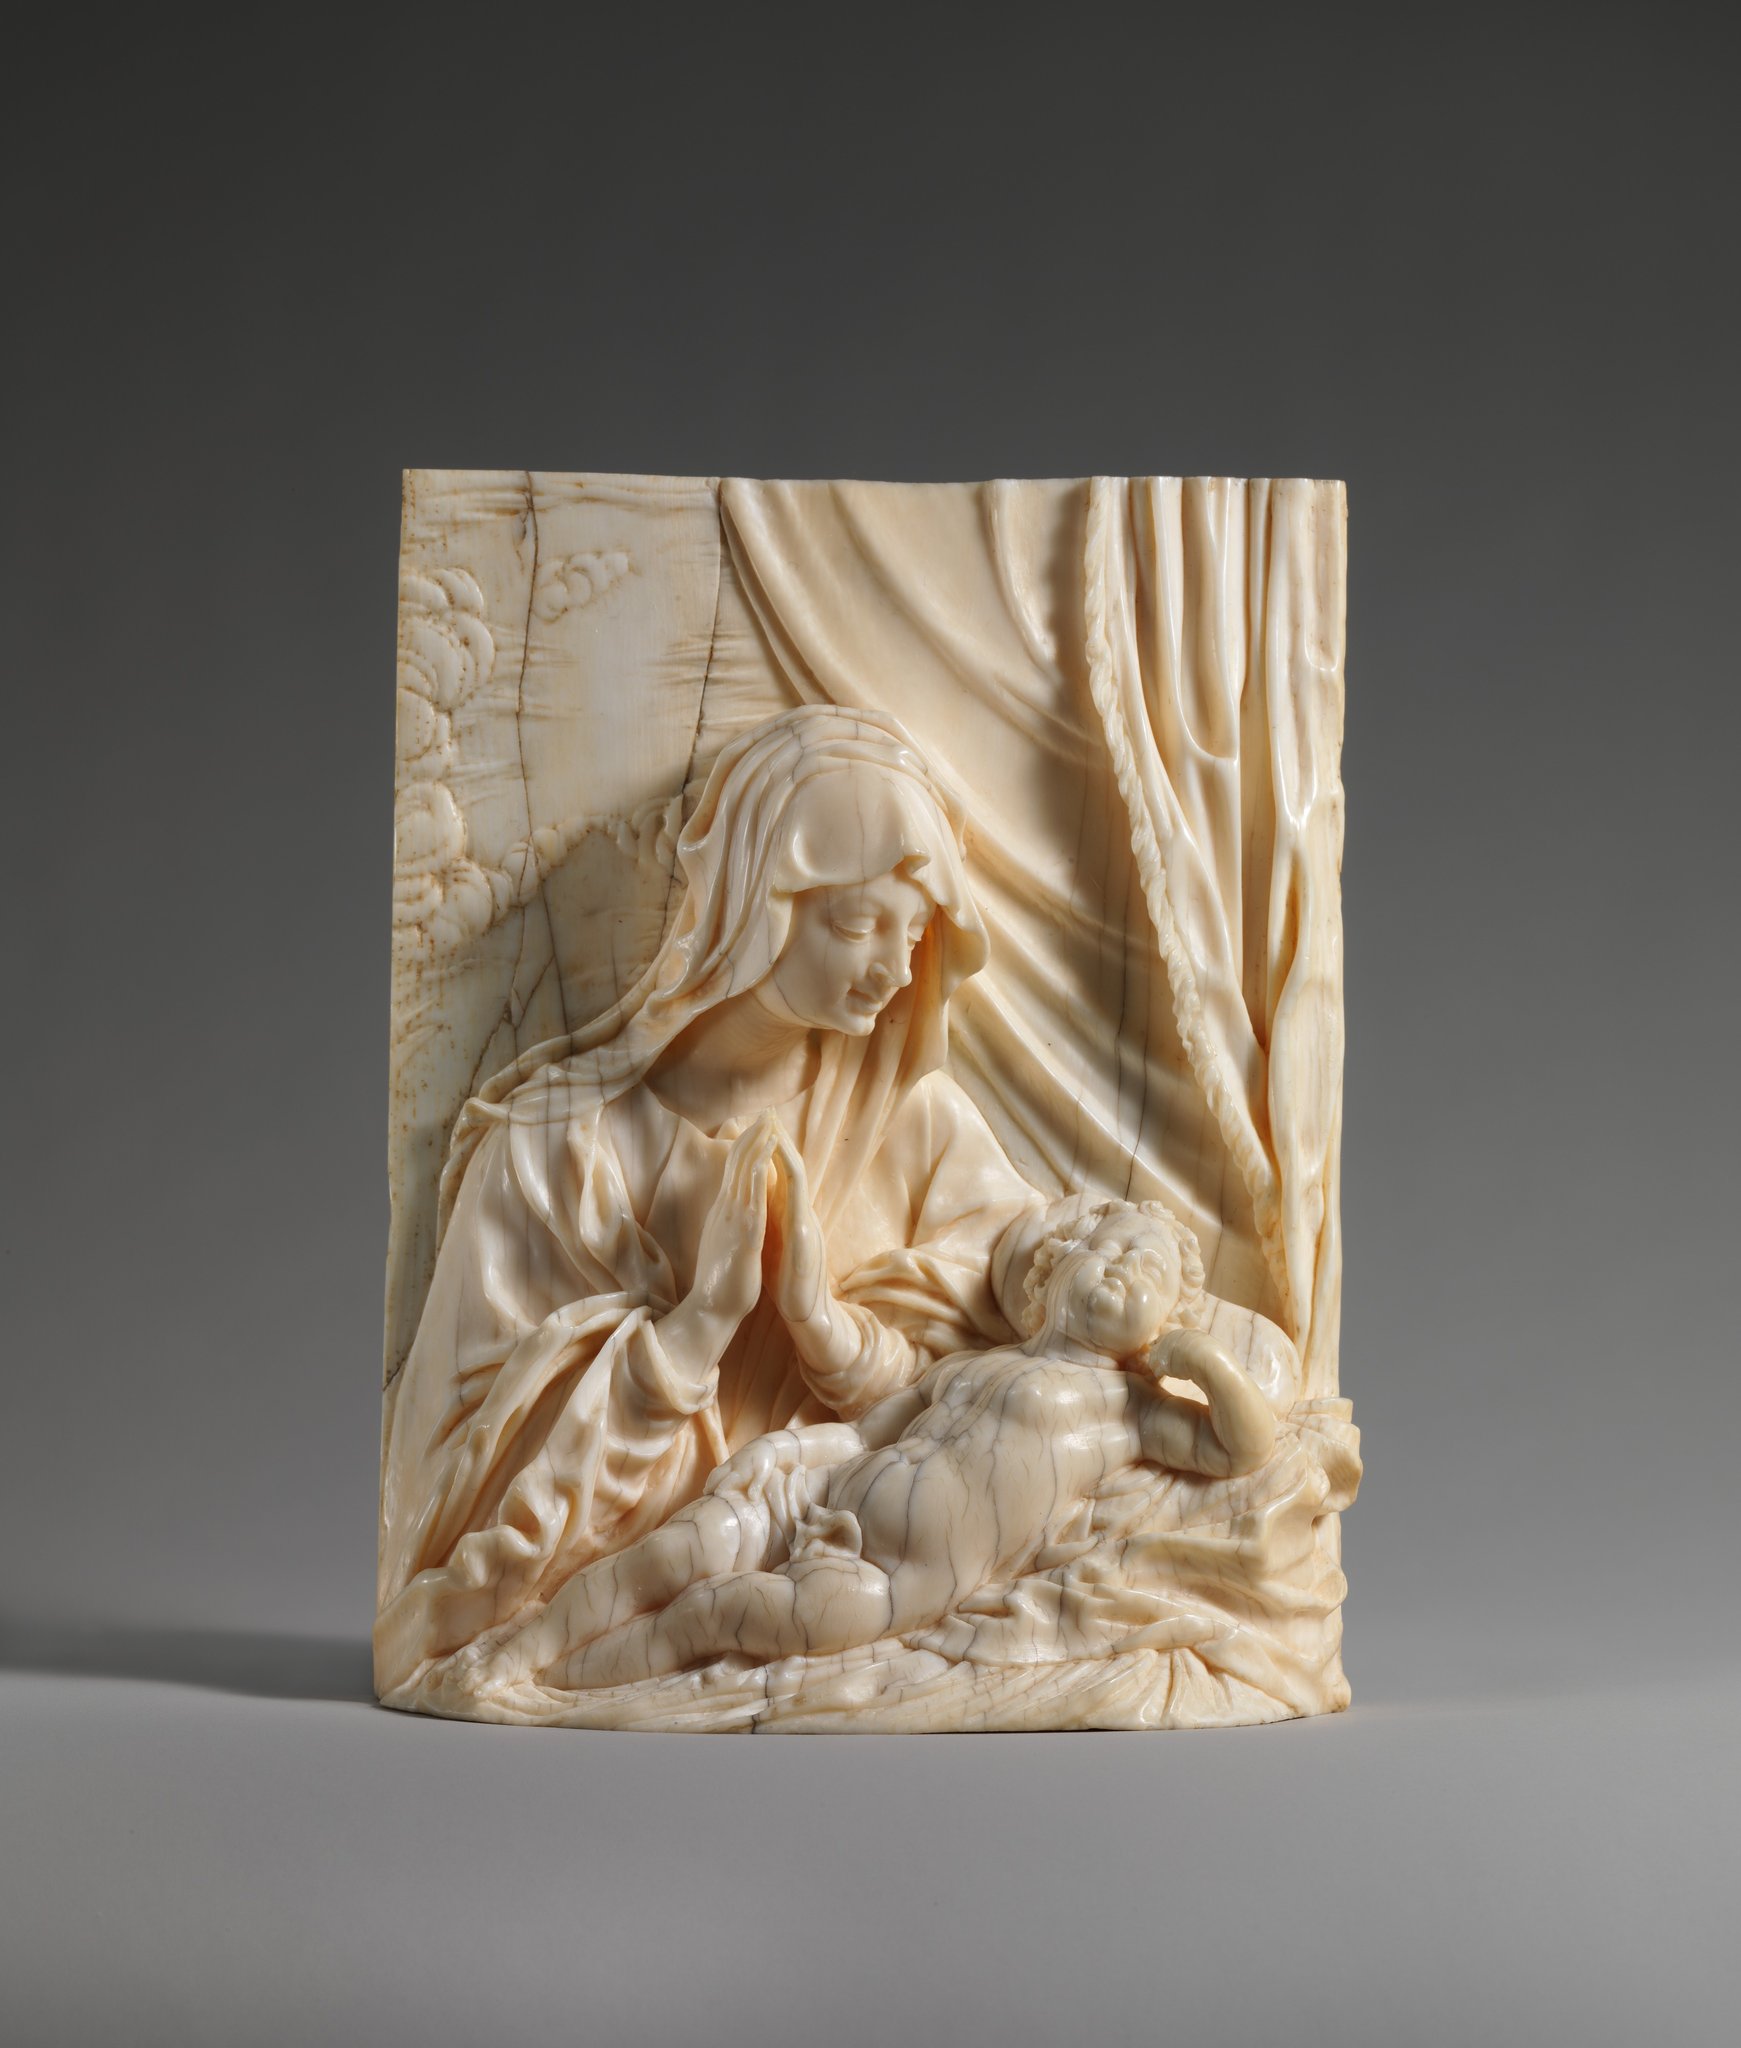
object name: relief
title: Madonna and Child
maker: jürgen kriebel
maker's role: artist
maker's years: 1580-1645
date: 1620-1625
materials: ivory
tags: madonna and child